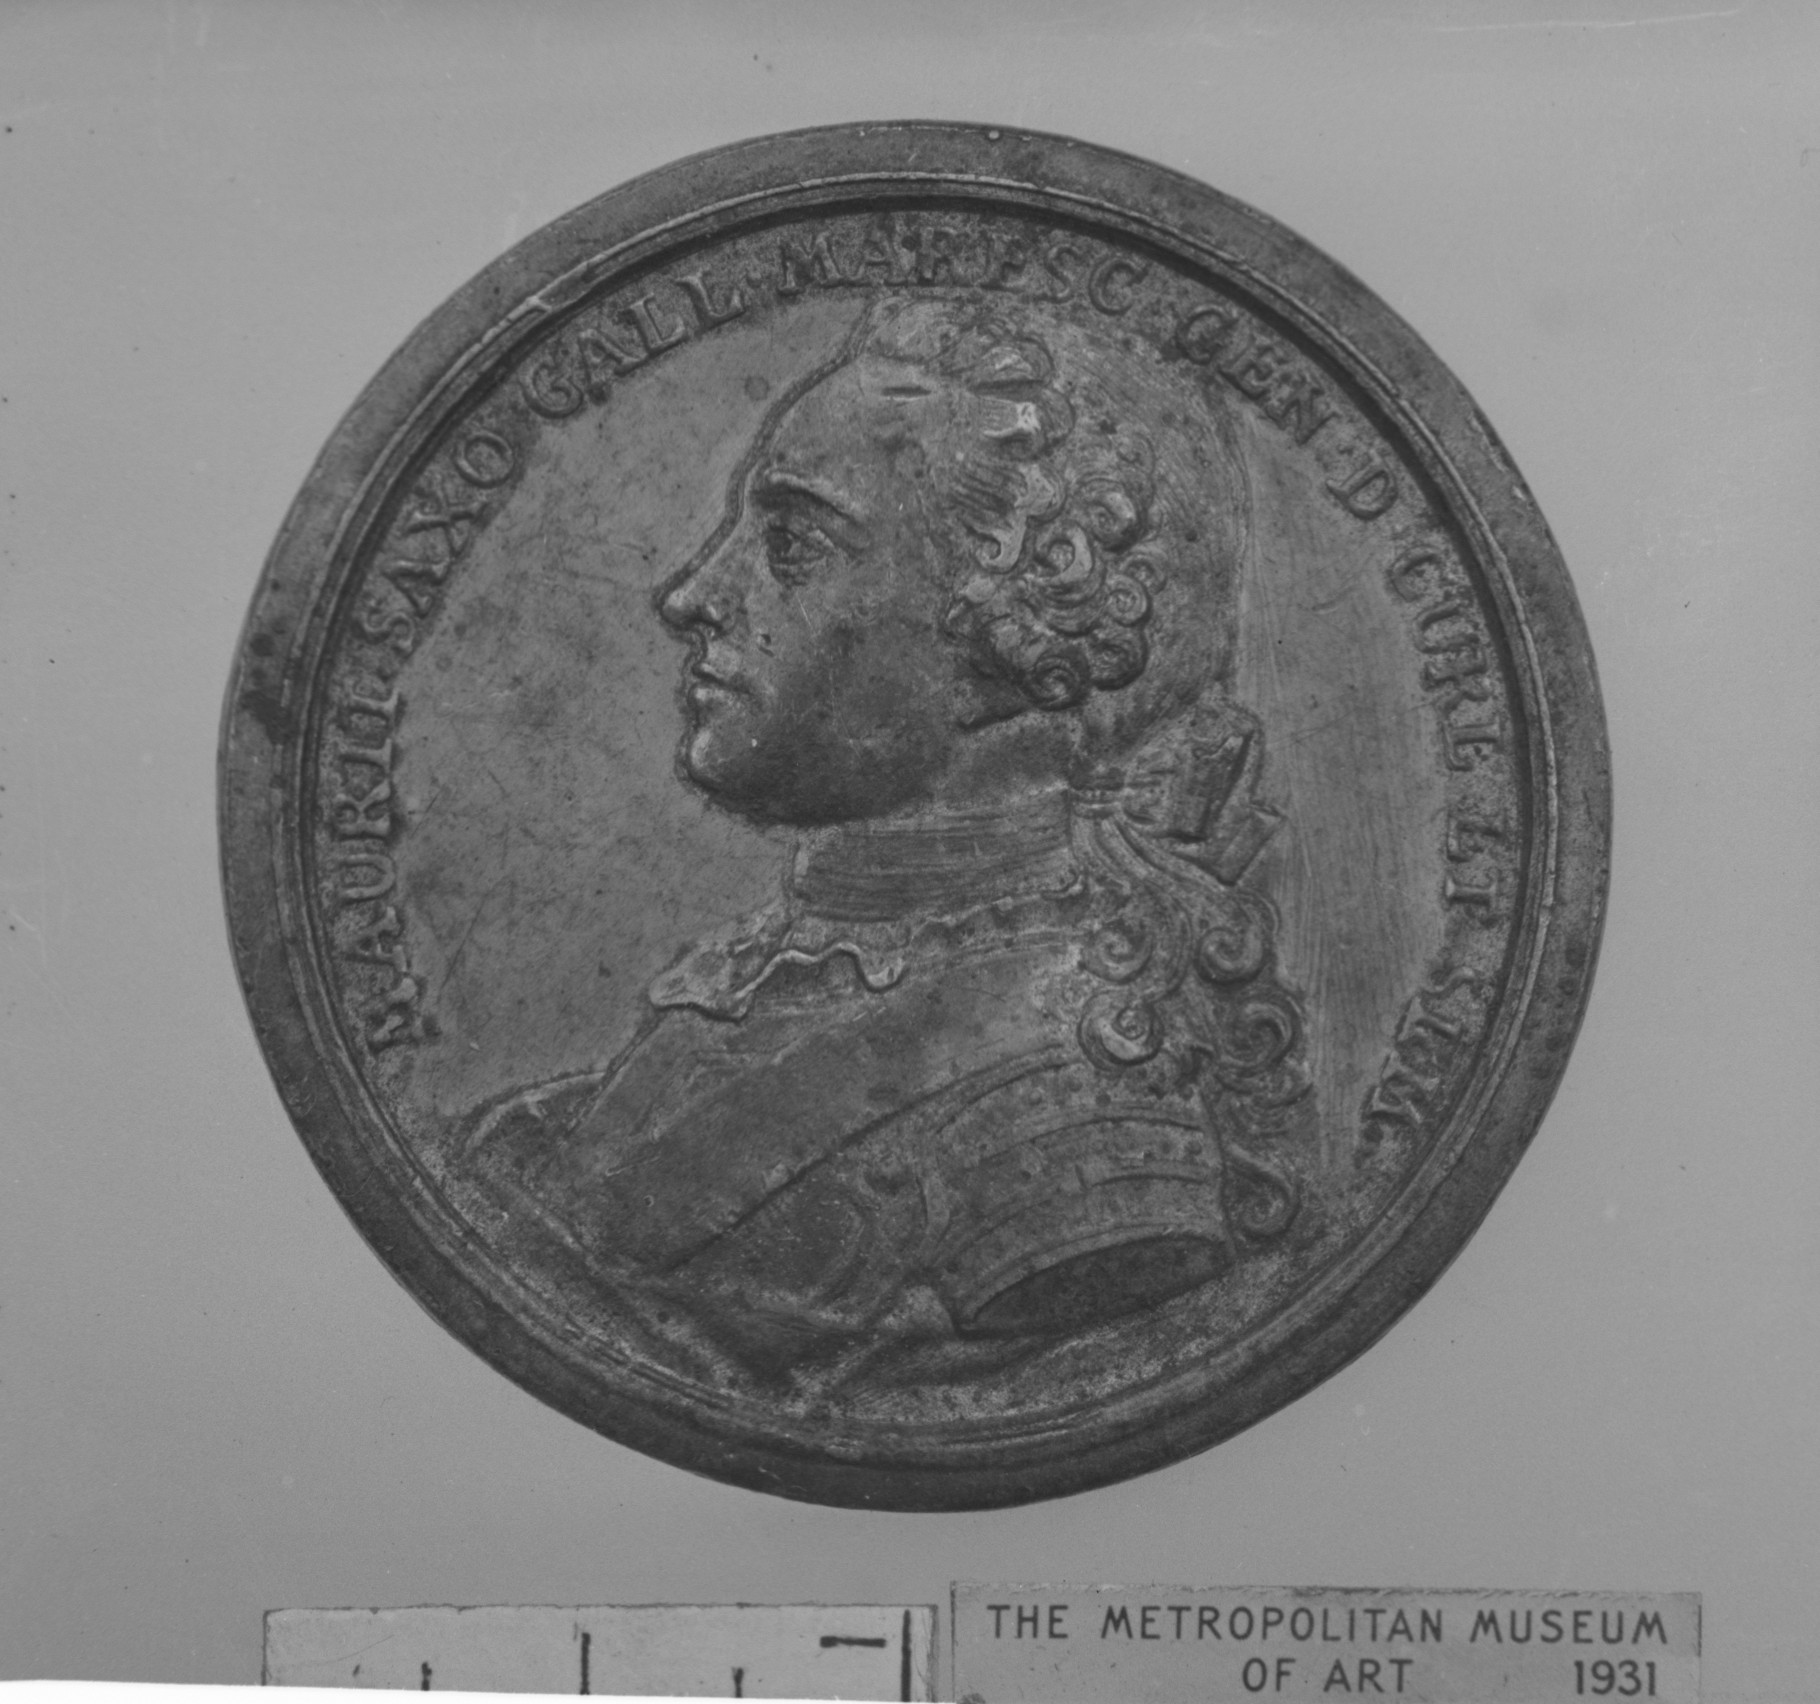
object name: medal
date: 1701-1800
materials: lead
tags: men,profiles